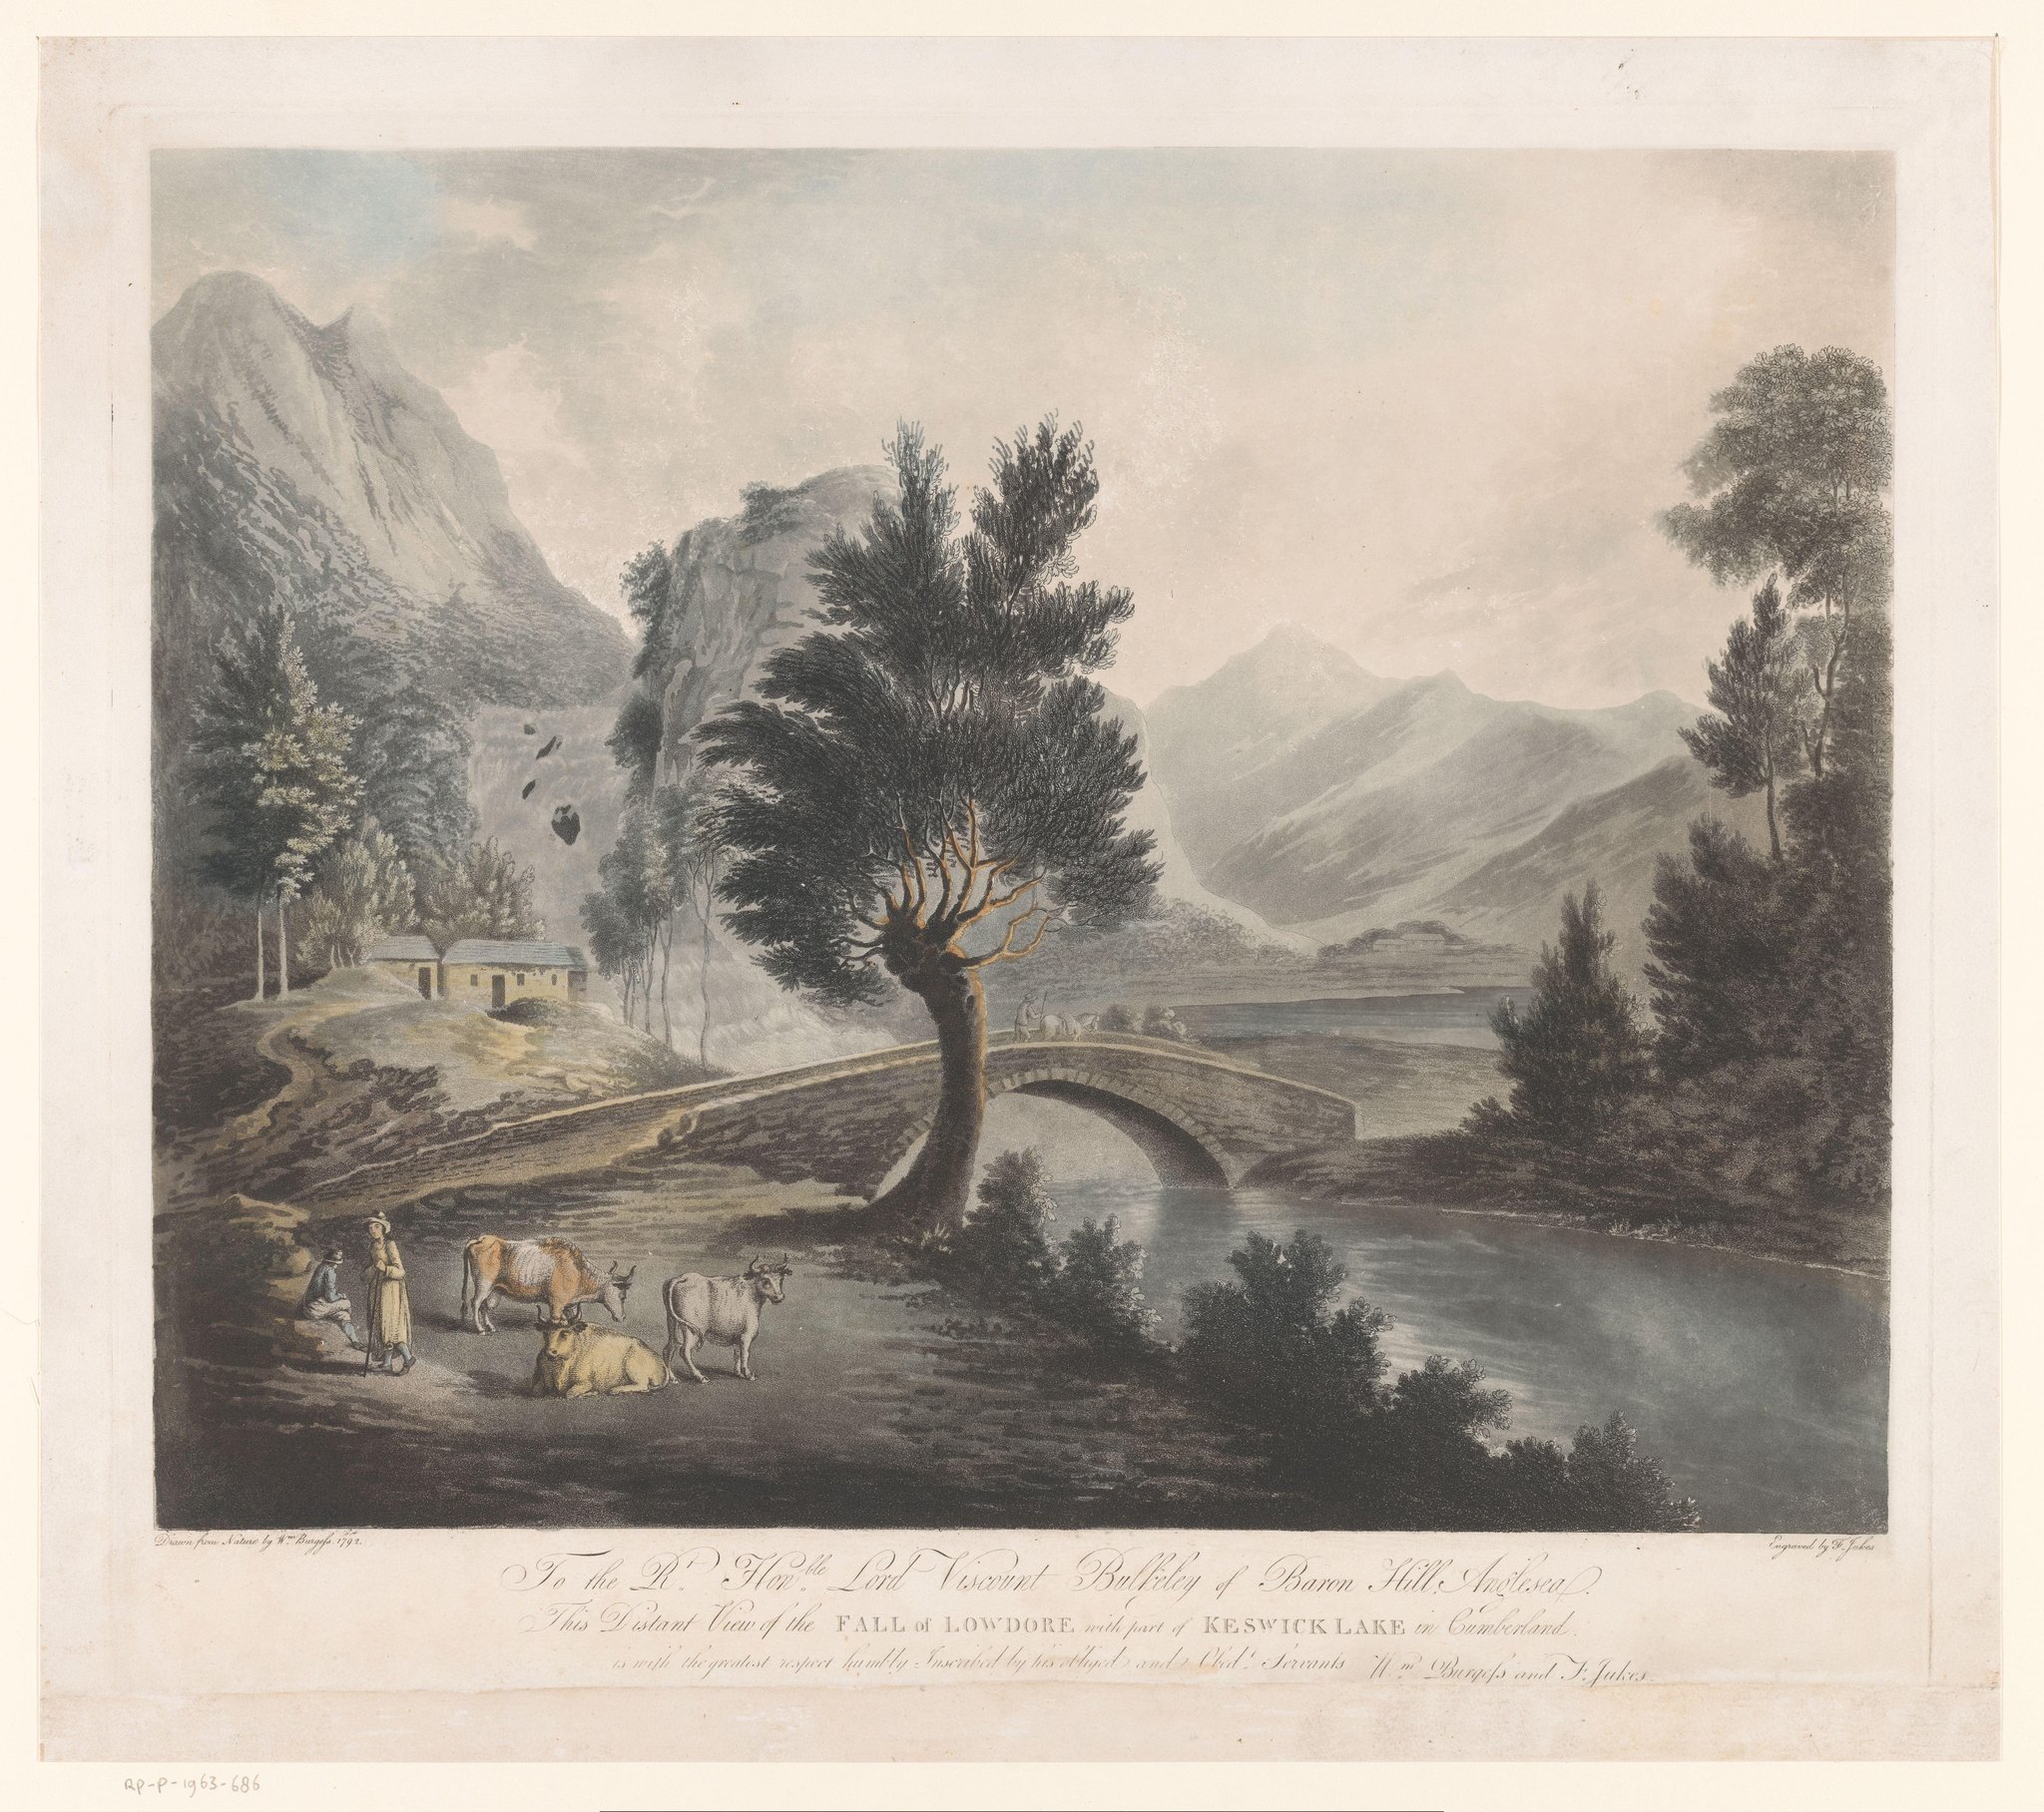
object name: print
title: Gezicht op het meer Keswick met de Lodore-watervallen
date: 1792-1794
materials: paper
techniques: aquatint, etching, hand coloring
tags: (high) hill, lake, river mouth, estuary, landscape with bridge, viaduct or aqueduct (+ city(-scape) with figures, staffage)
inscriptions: collector's mark: Lugt 2228